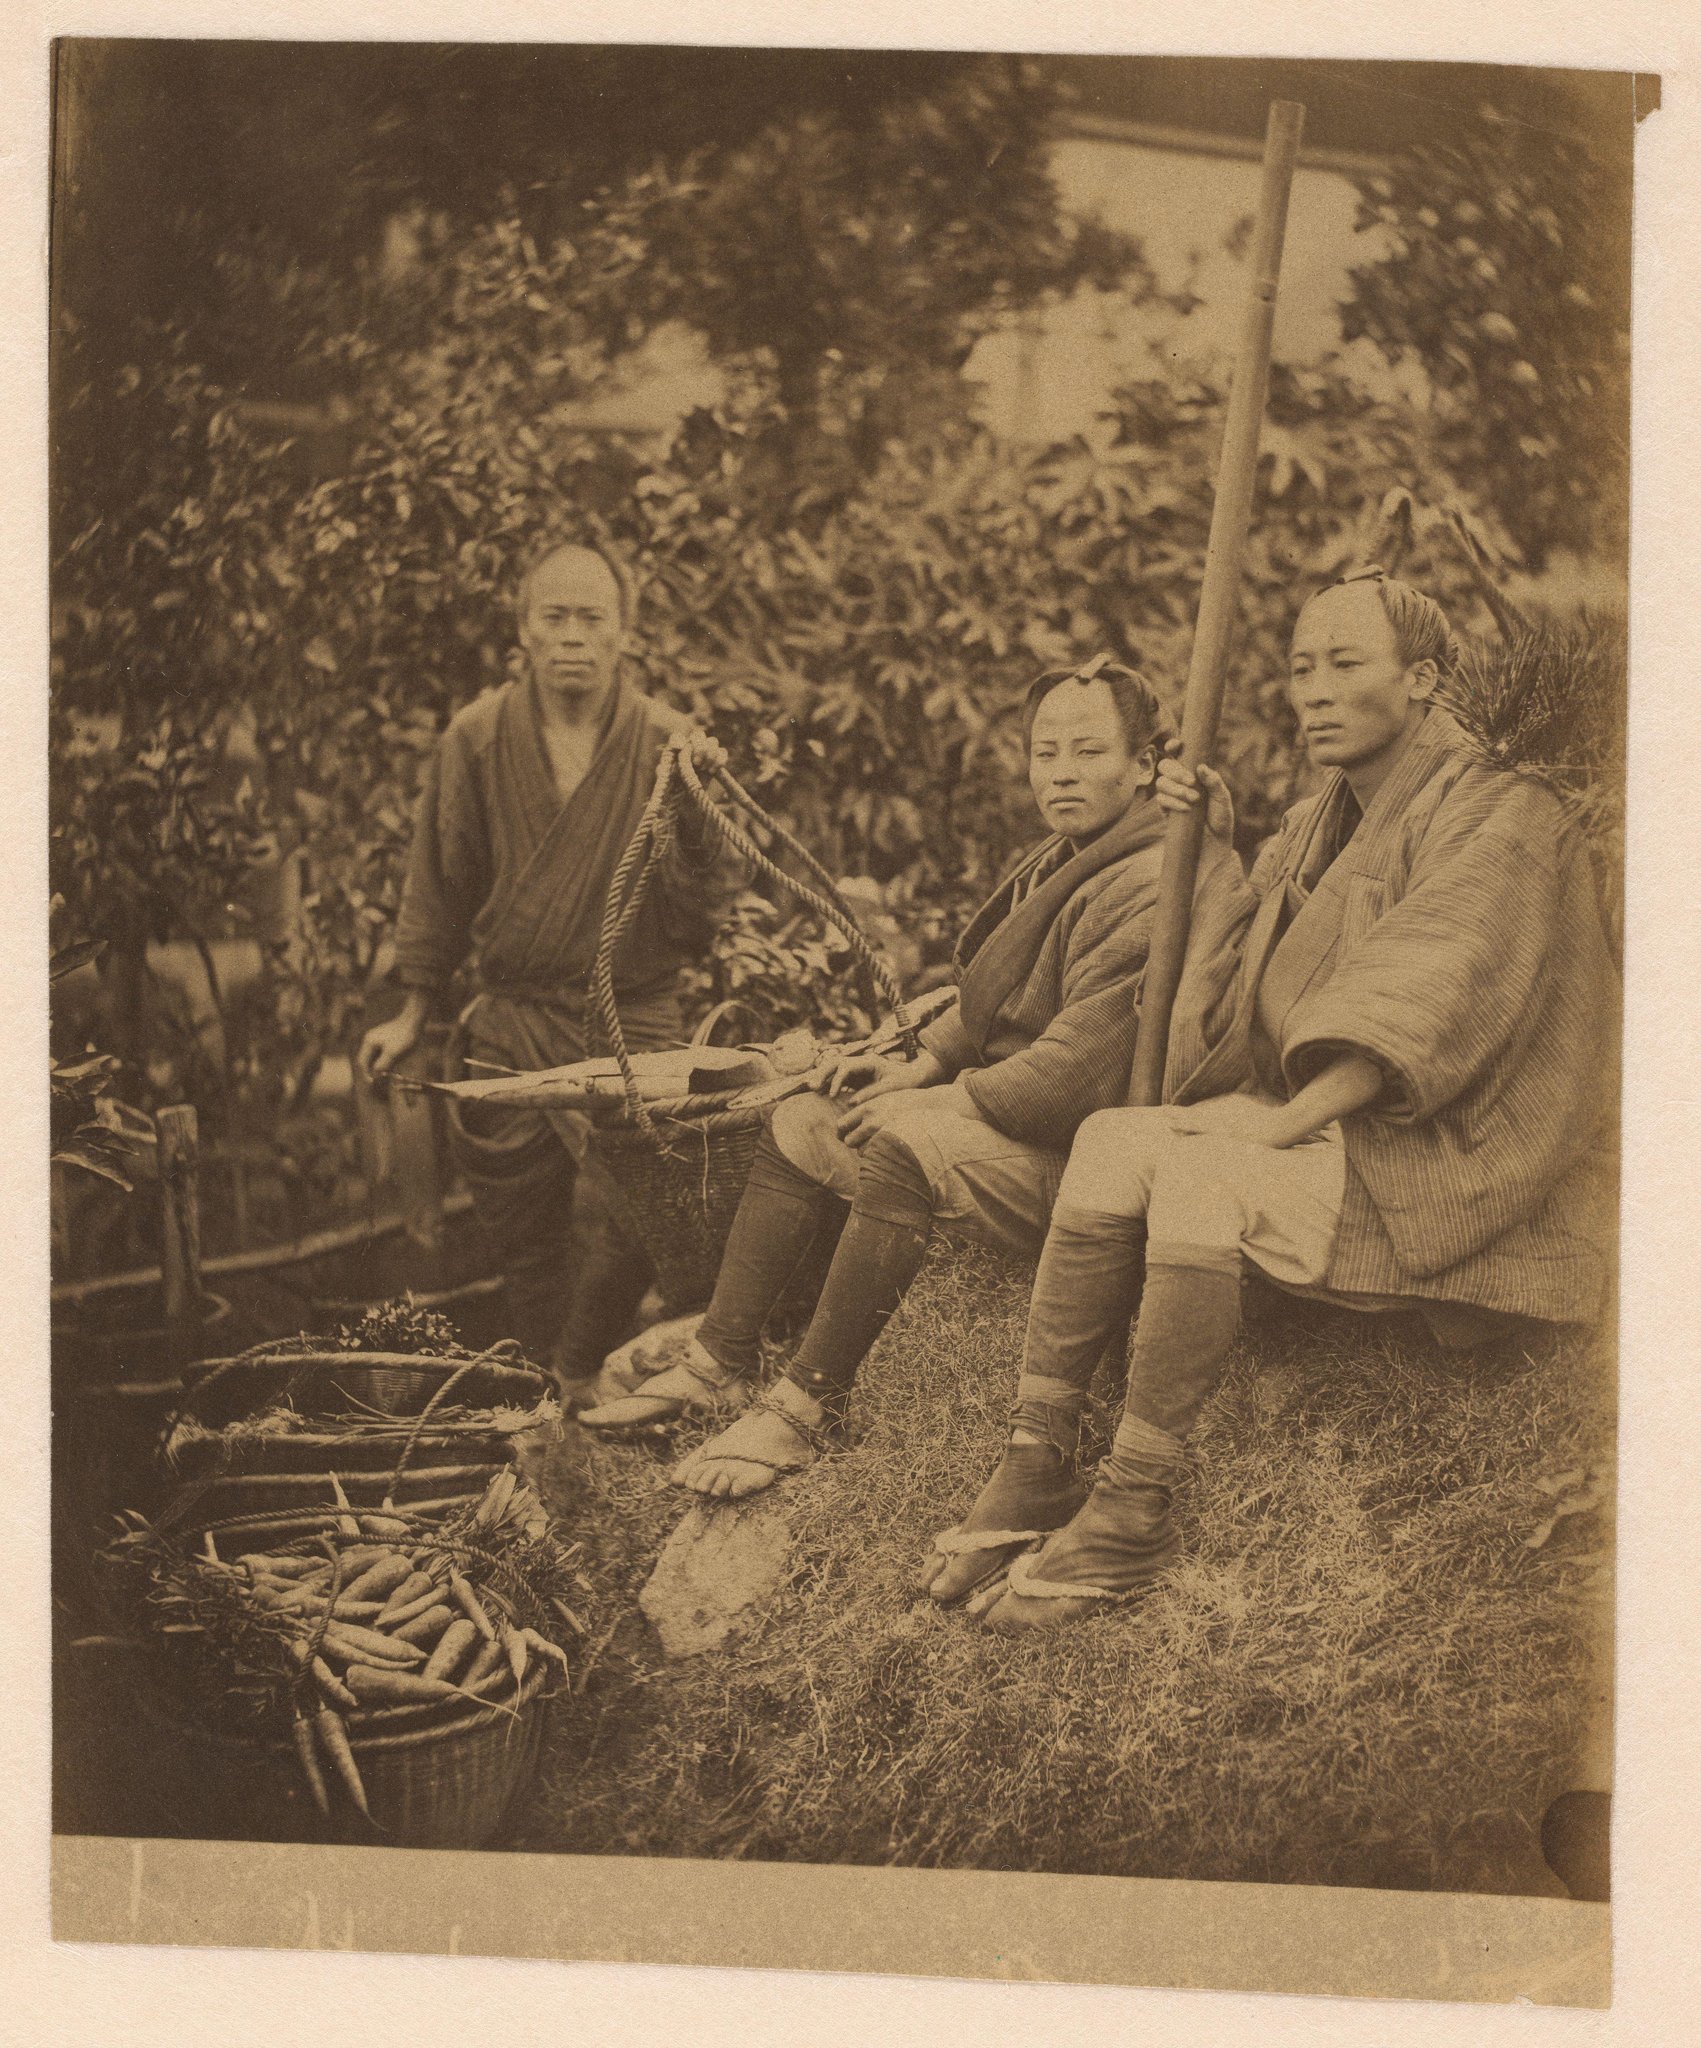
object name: photograph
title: Portret van drie boeren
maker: antoon bauduin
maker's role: amateurfotograaf, hoogleraar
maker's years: 1820-1885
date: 1862-1866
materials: paper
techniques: albumen print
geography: japan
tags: historical persons not known by name, japan